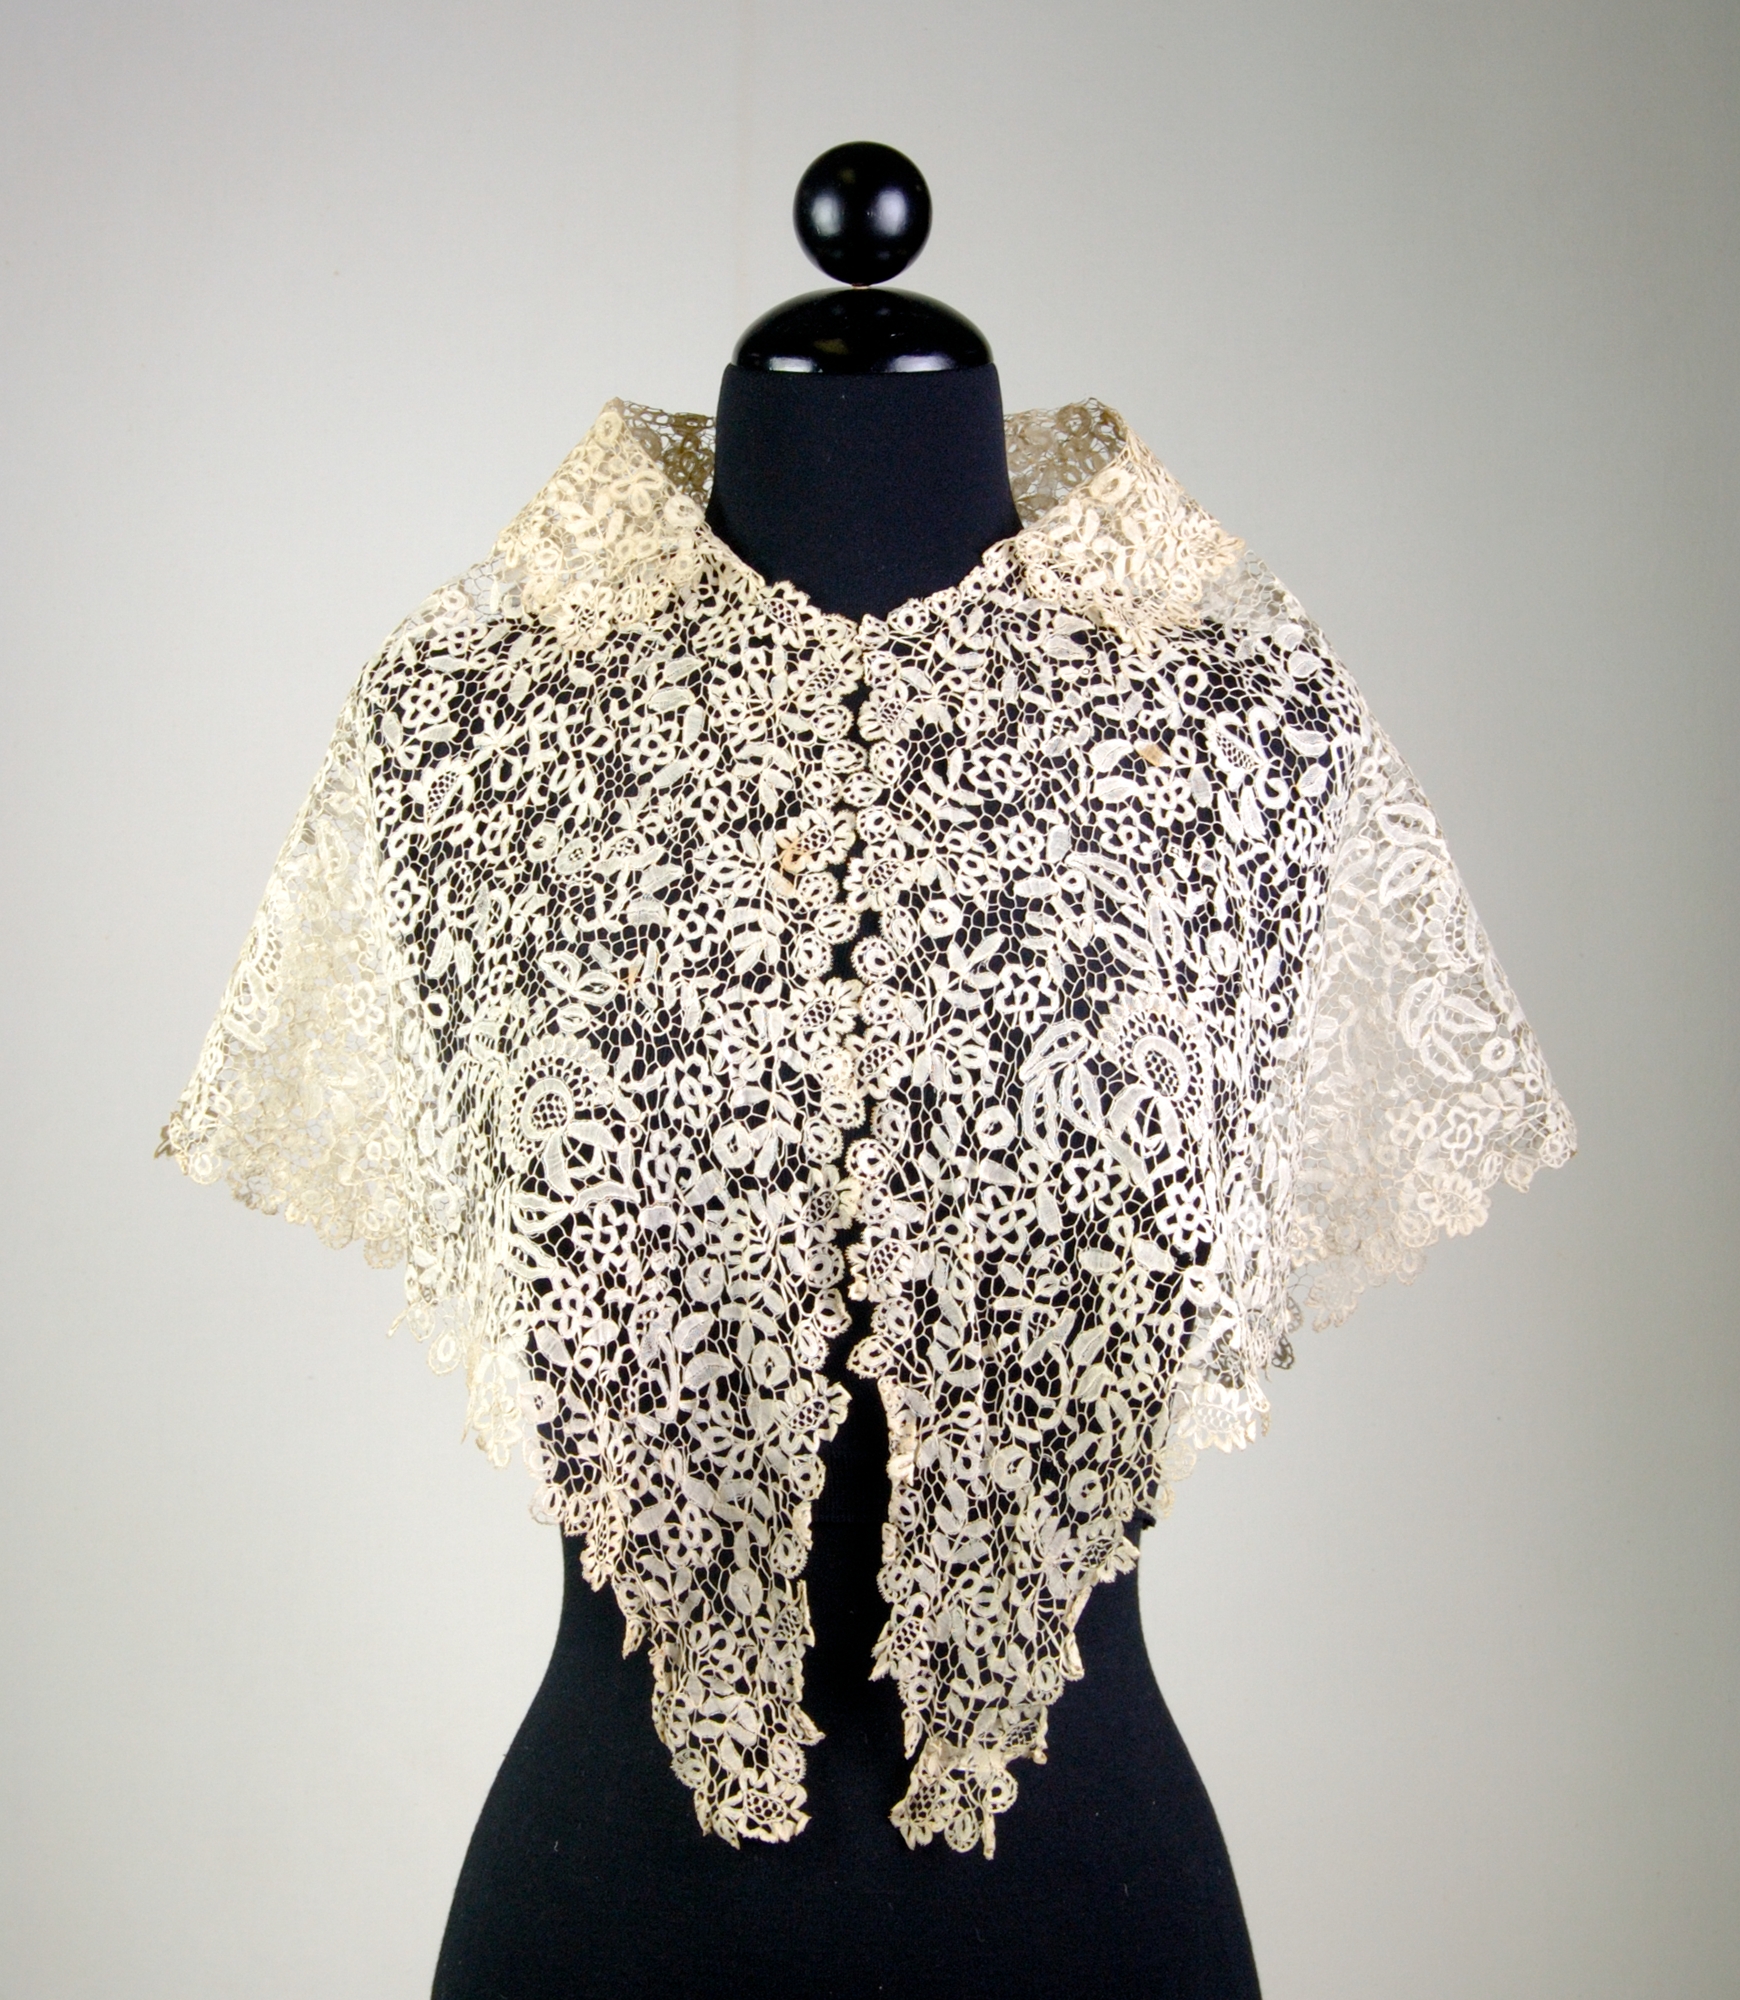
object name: pelerine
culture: british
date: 1850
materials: linen